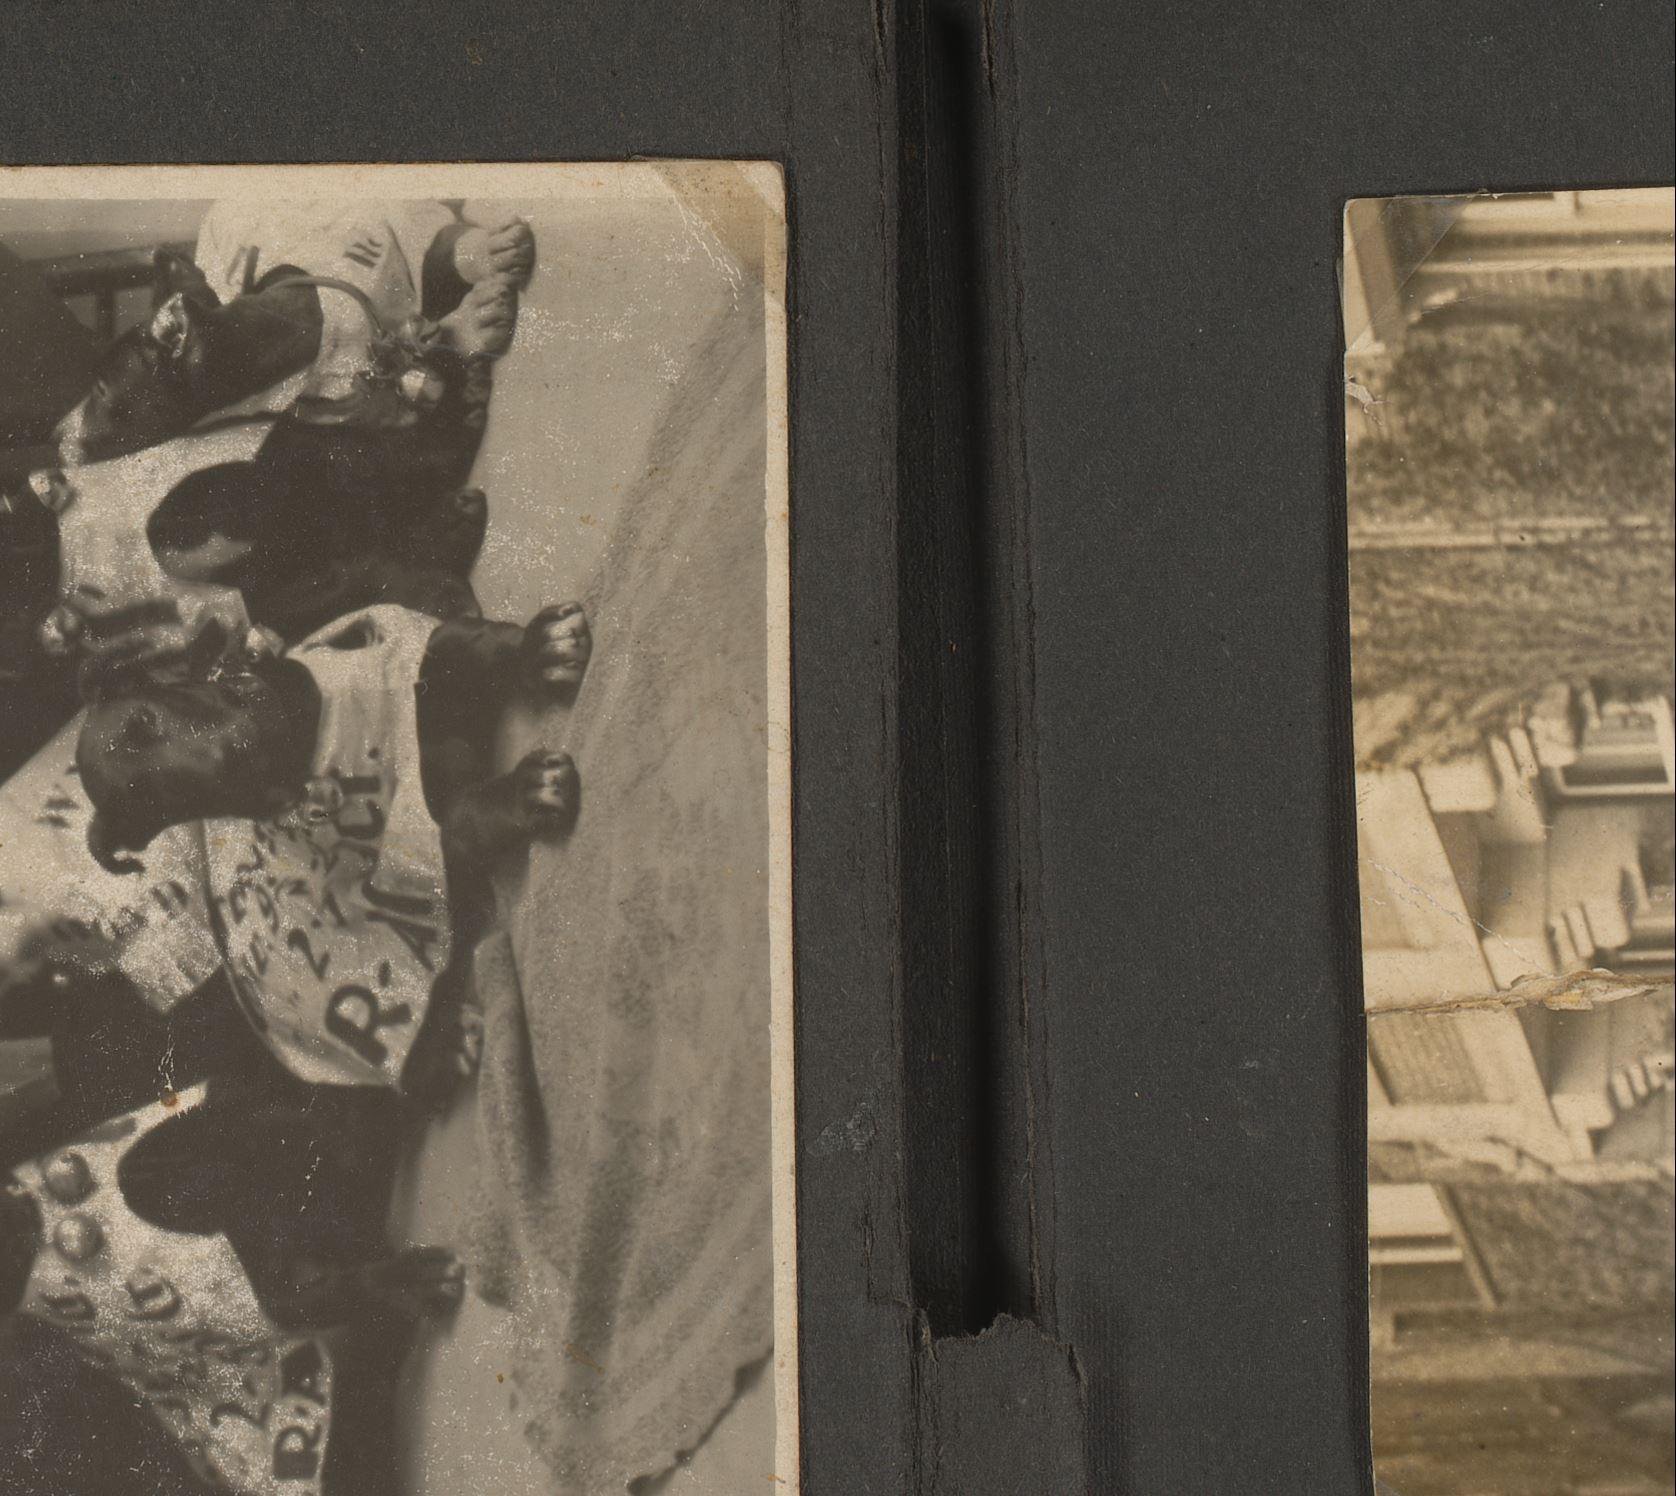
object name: photograph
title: Portret man en vrouw met vier honden van drie maanden met reclameteksten om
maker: Anonymous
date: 1930-1940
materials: photographic support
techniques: gelatin silver print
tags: adult woman, advertising, adult man, historical persons, dog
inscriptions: annotation: ‘Jonge Honden/ 3 Maanden’